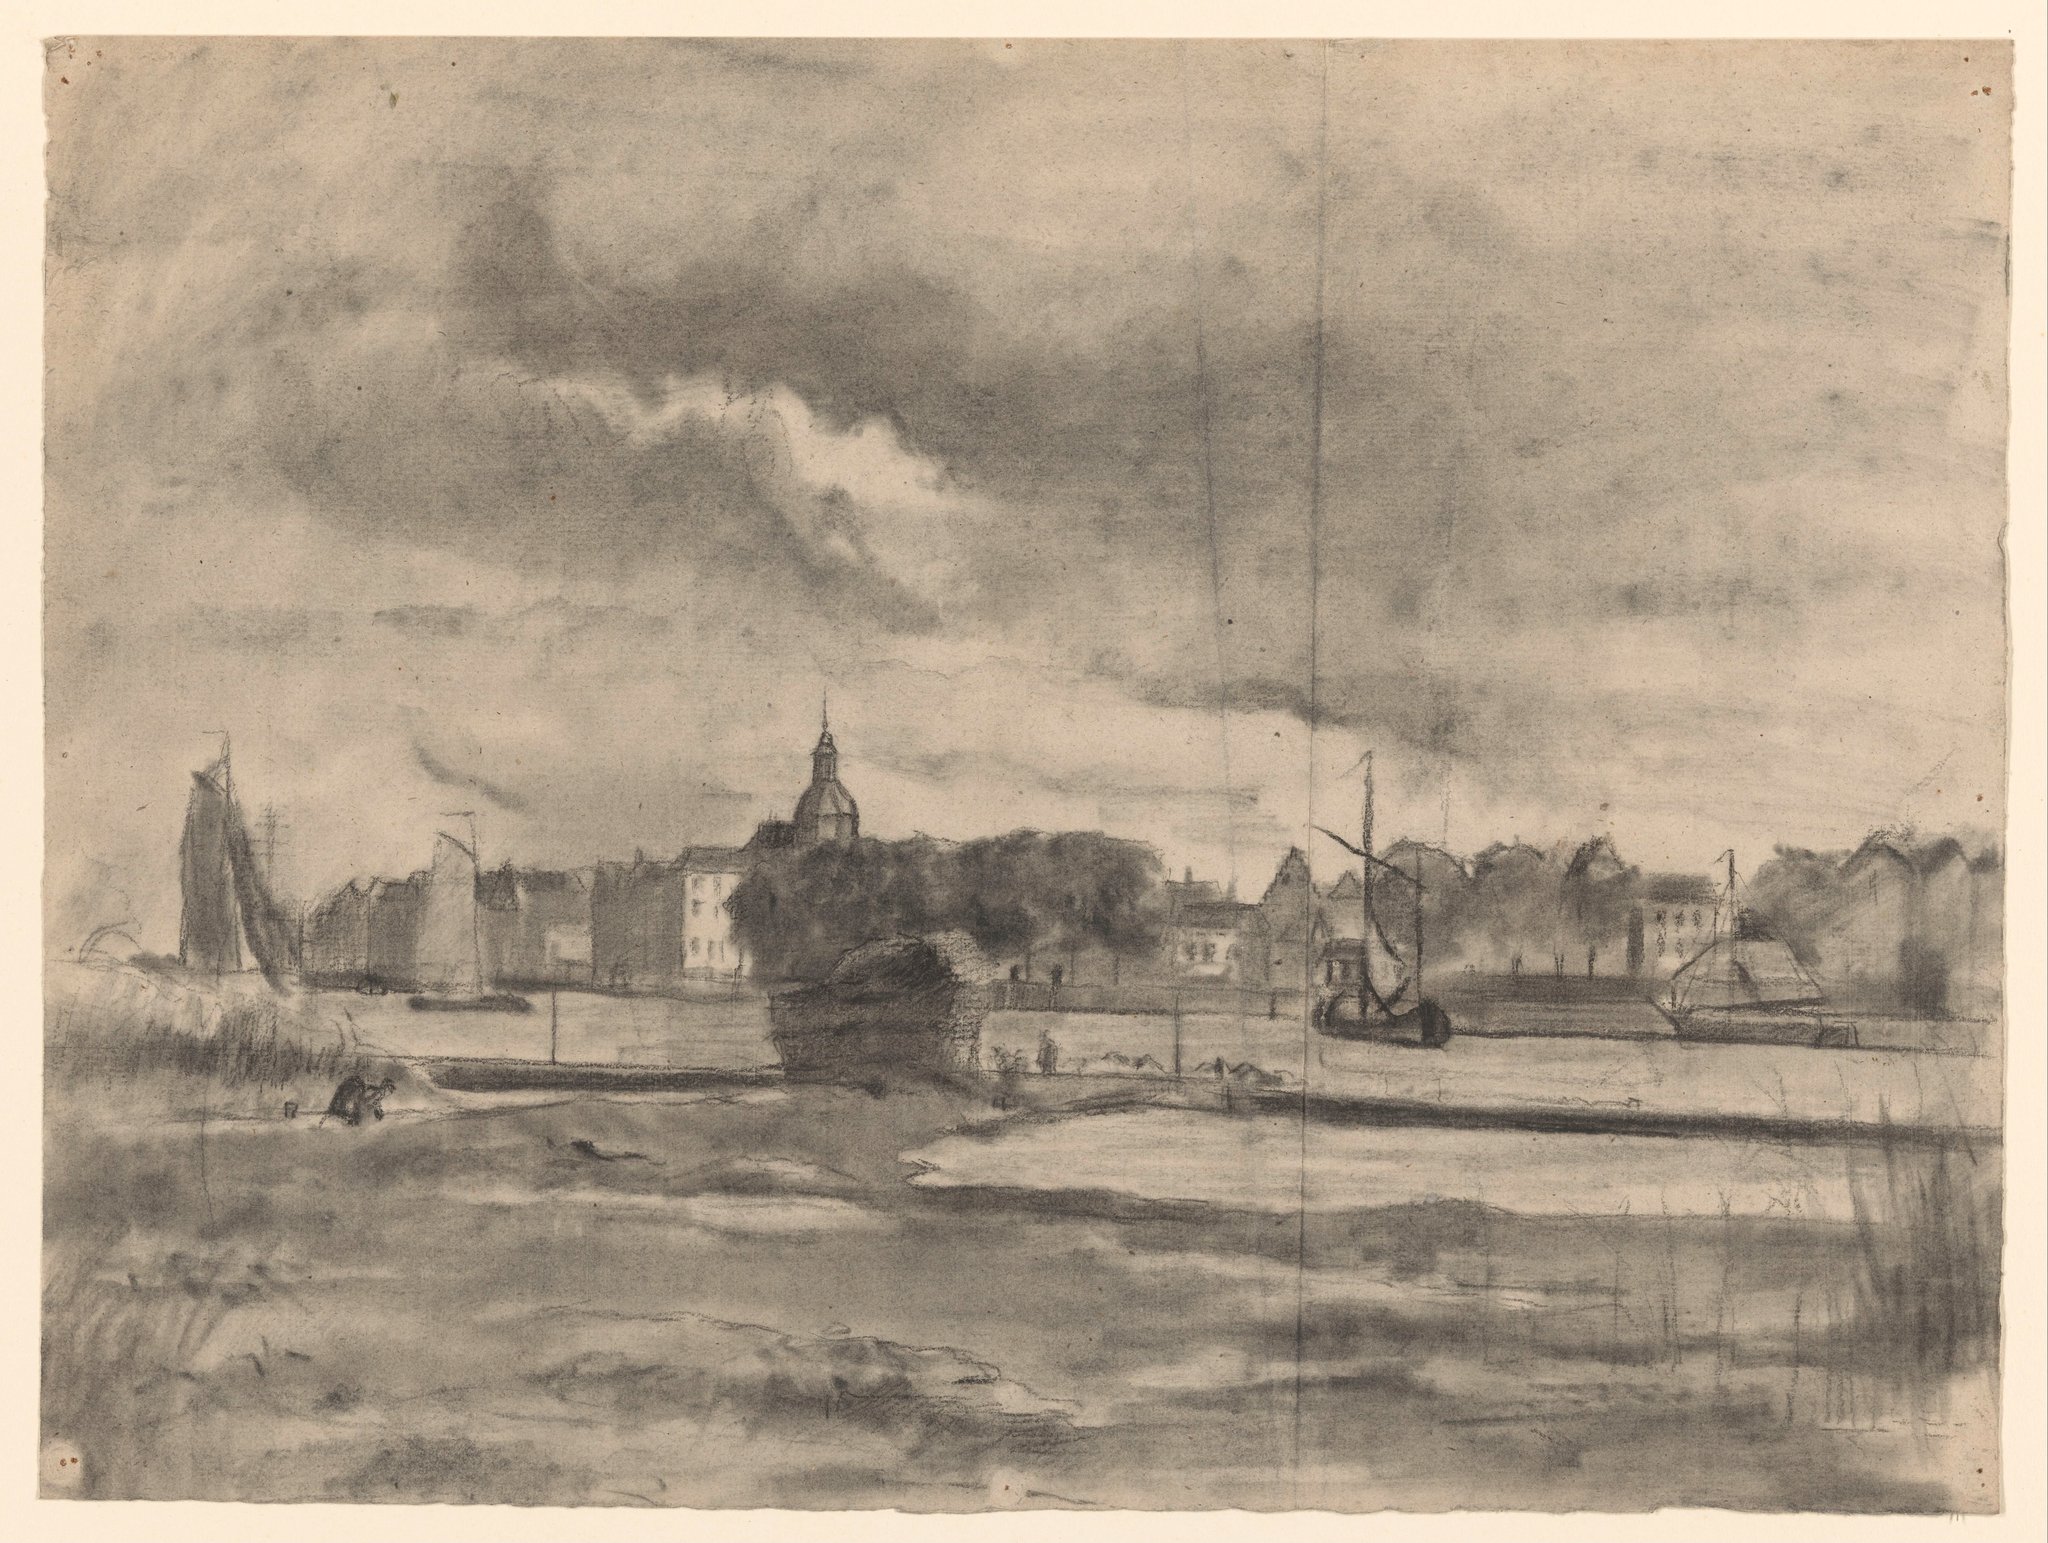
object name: drawing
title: Stad aan een rivier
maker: jan veth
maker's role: designer, draughtsman, painter, print maker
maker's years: 1864-1925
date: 1874-1925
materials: charcoal, paper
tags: river, prospect of city, town panorama, silhouette of city